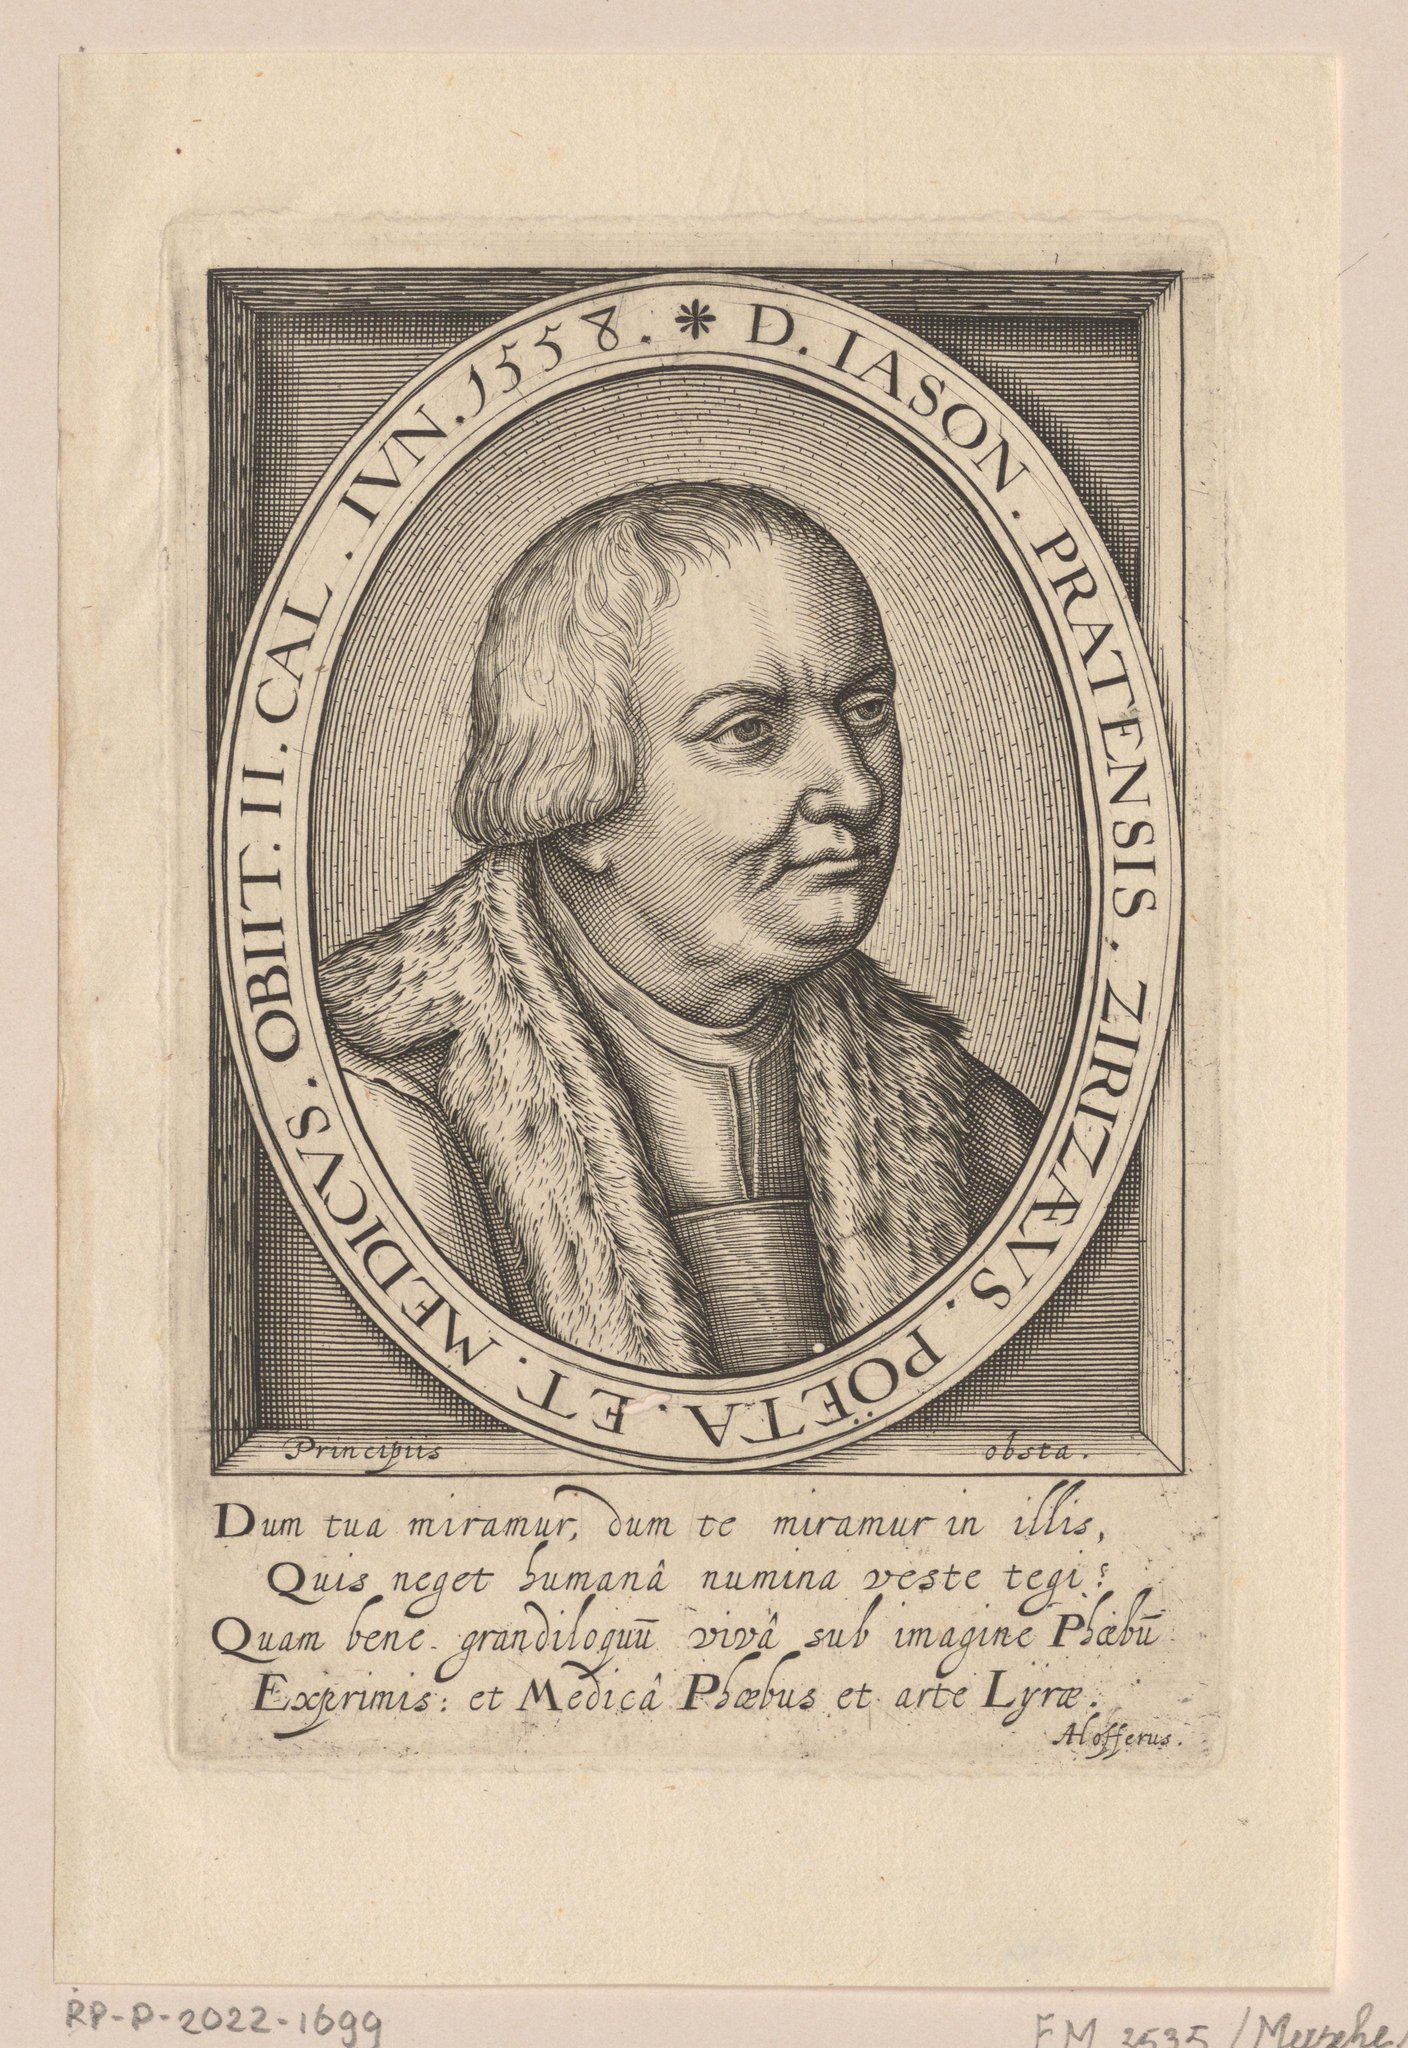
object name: print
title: Portret van Jason Pratensis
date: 1558-1699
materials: paper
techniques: engraving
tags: historical persons, portrait of a writer